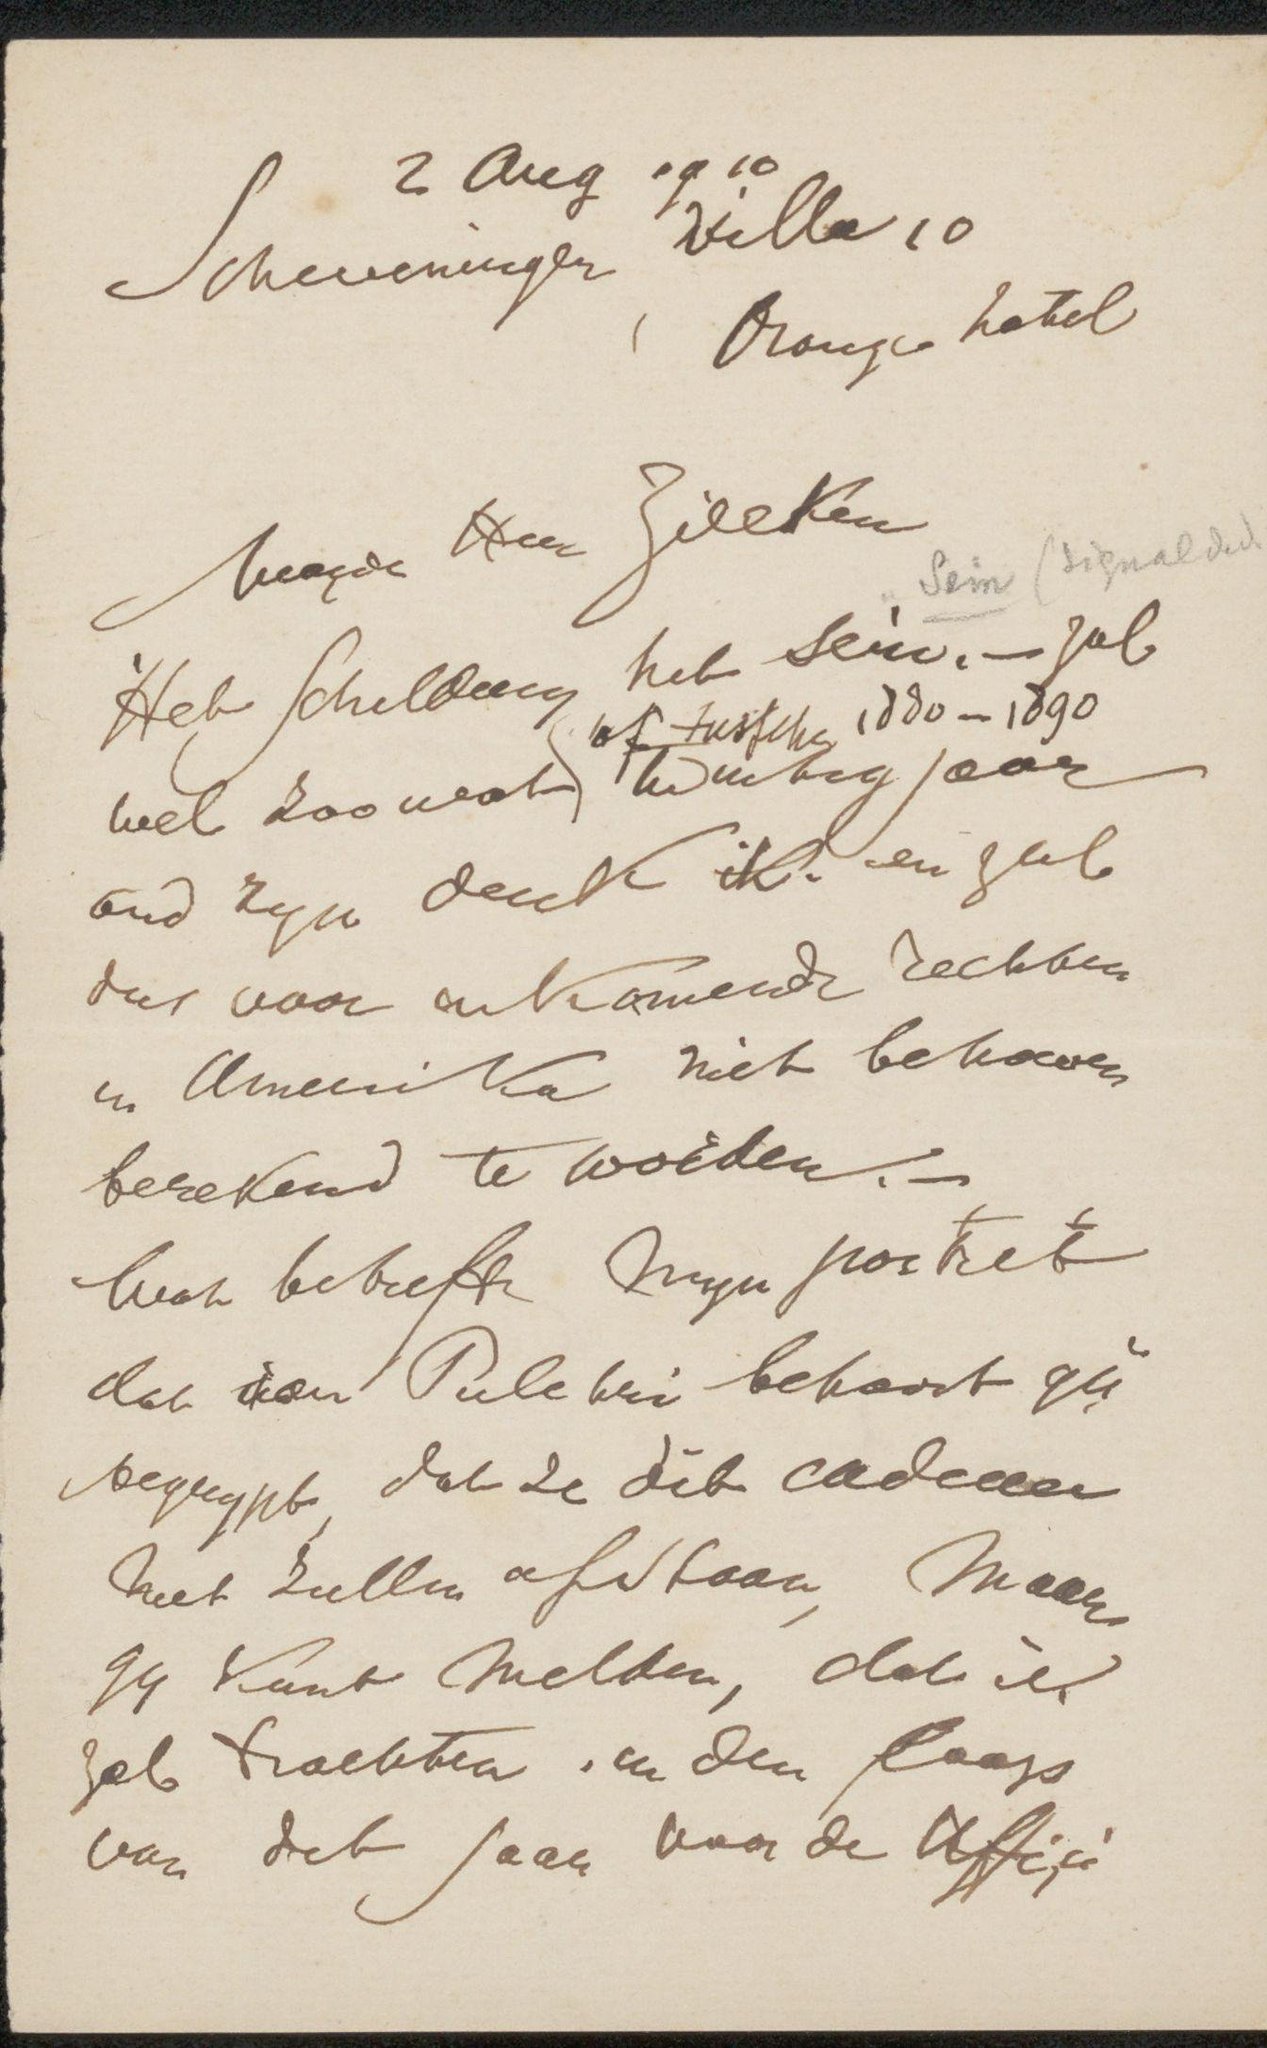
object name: letter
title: Brief aan Philip Zilcken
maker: jozef israëls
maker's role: draughtsman, painter, print maker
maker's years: 1824-1911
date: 1910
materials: ink, paper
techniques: pen, writing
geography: scheveningen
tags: print maker, jozef israëls, the hague, painter, draughtsman, philip zilcken, historical persons (portraits and scenes from the life)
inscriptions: collector's mark: ‘RPK’